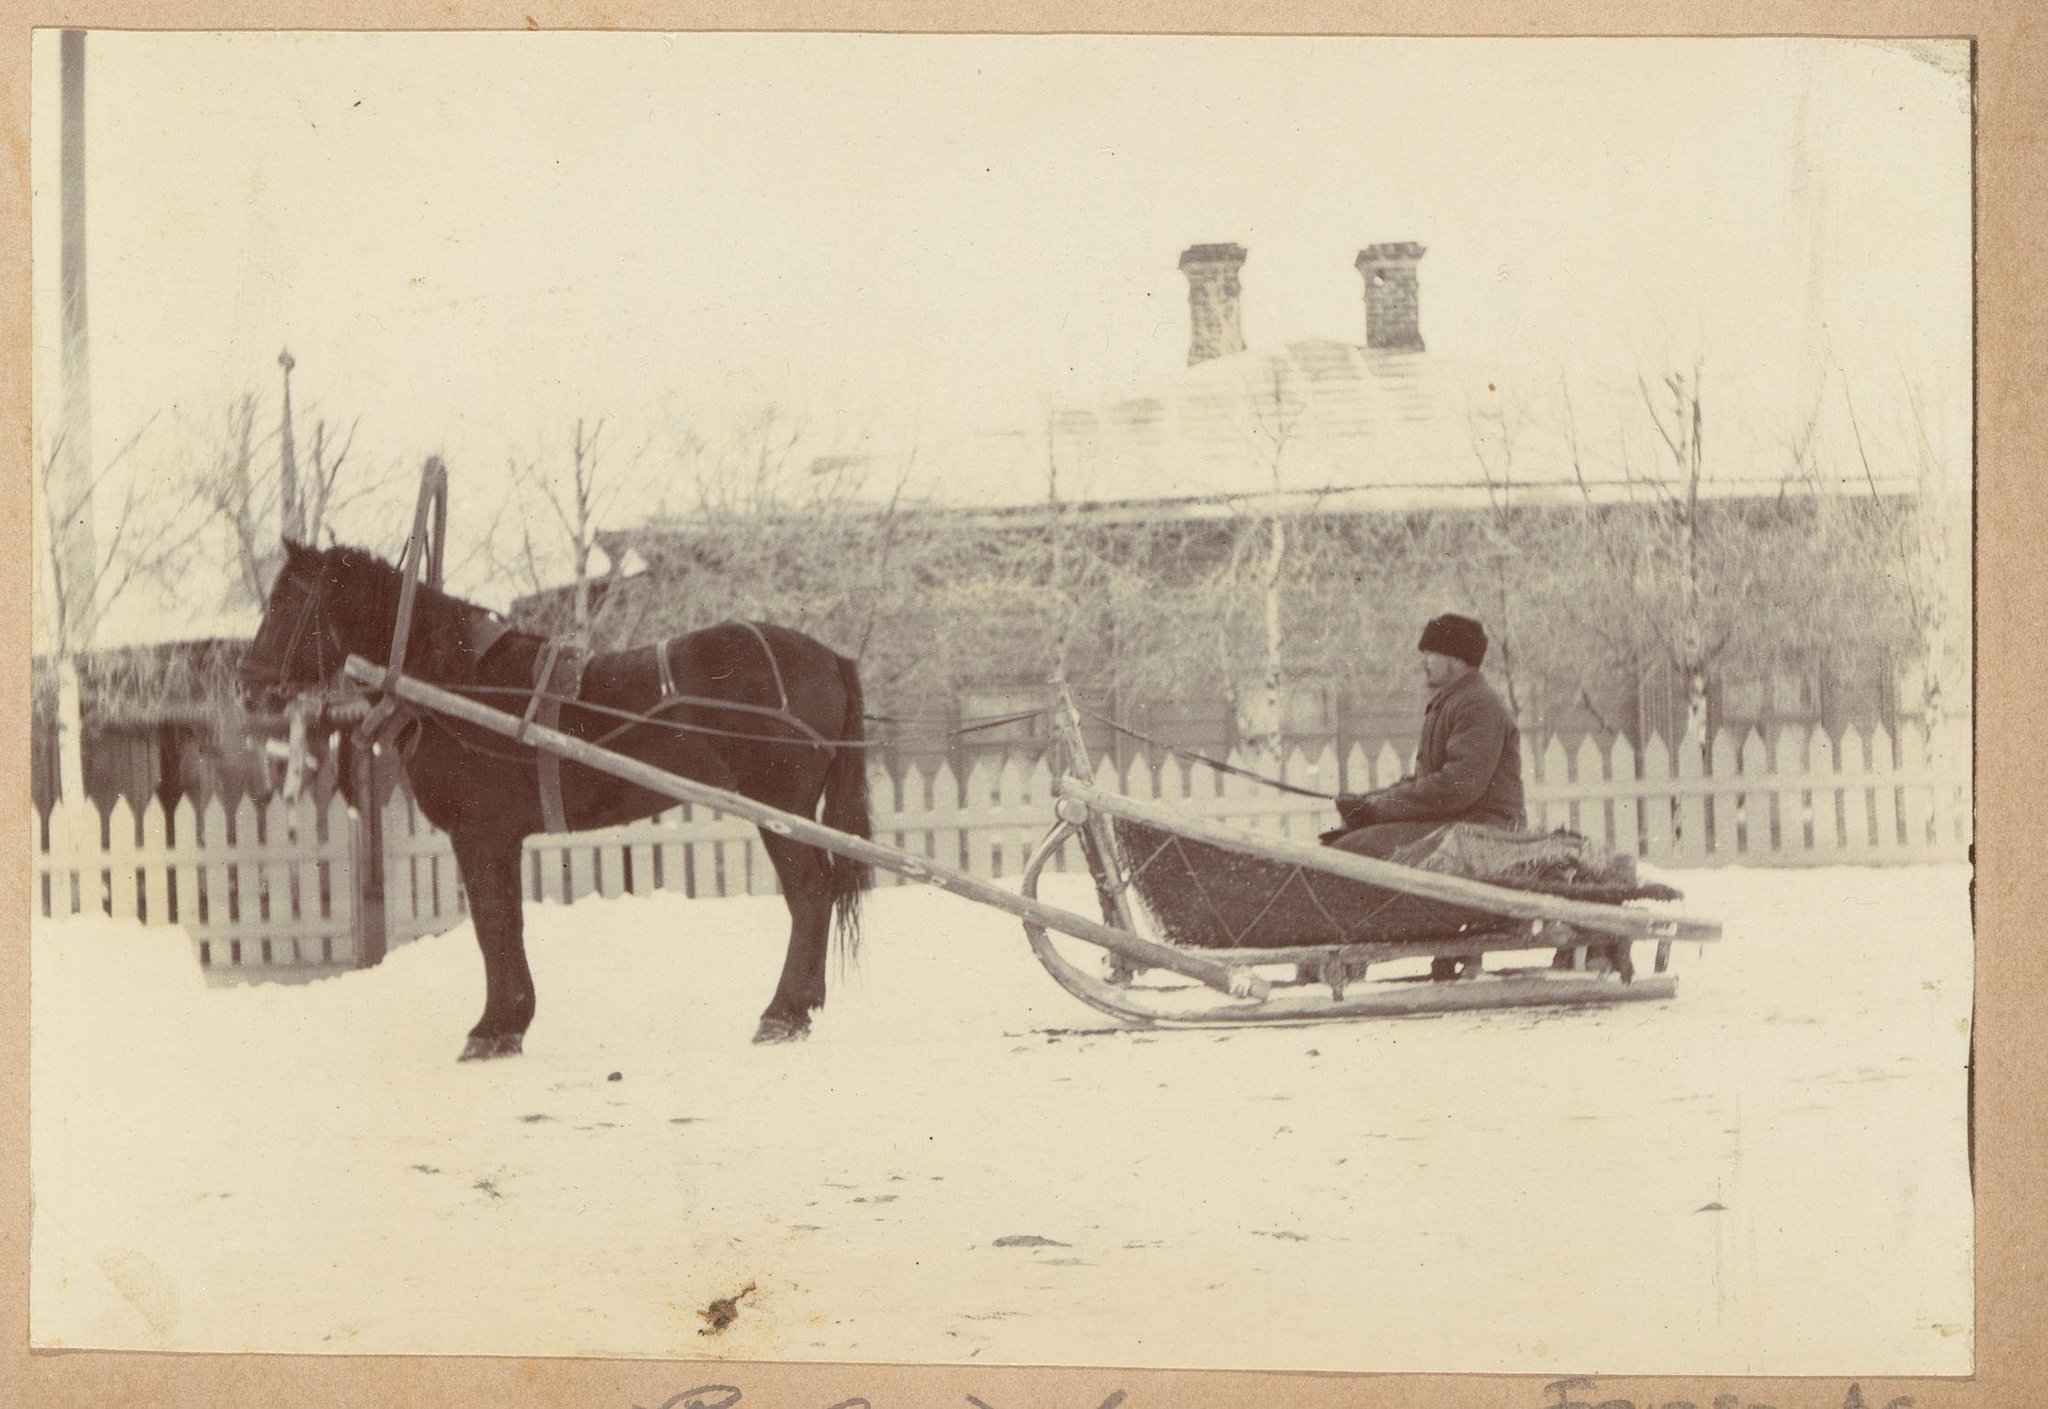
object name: photograph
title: Man op een paardenslee in Rusland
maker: joseph cheetham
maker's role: engineer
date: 1903-1904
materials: photographic support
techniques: gelatin silver print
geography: russia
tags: horse-sleigh, russia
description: Onderdeel van Fotoalbum van de Engelse familie Cheetham met opnames van hun verblijf in Rusland.